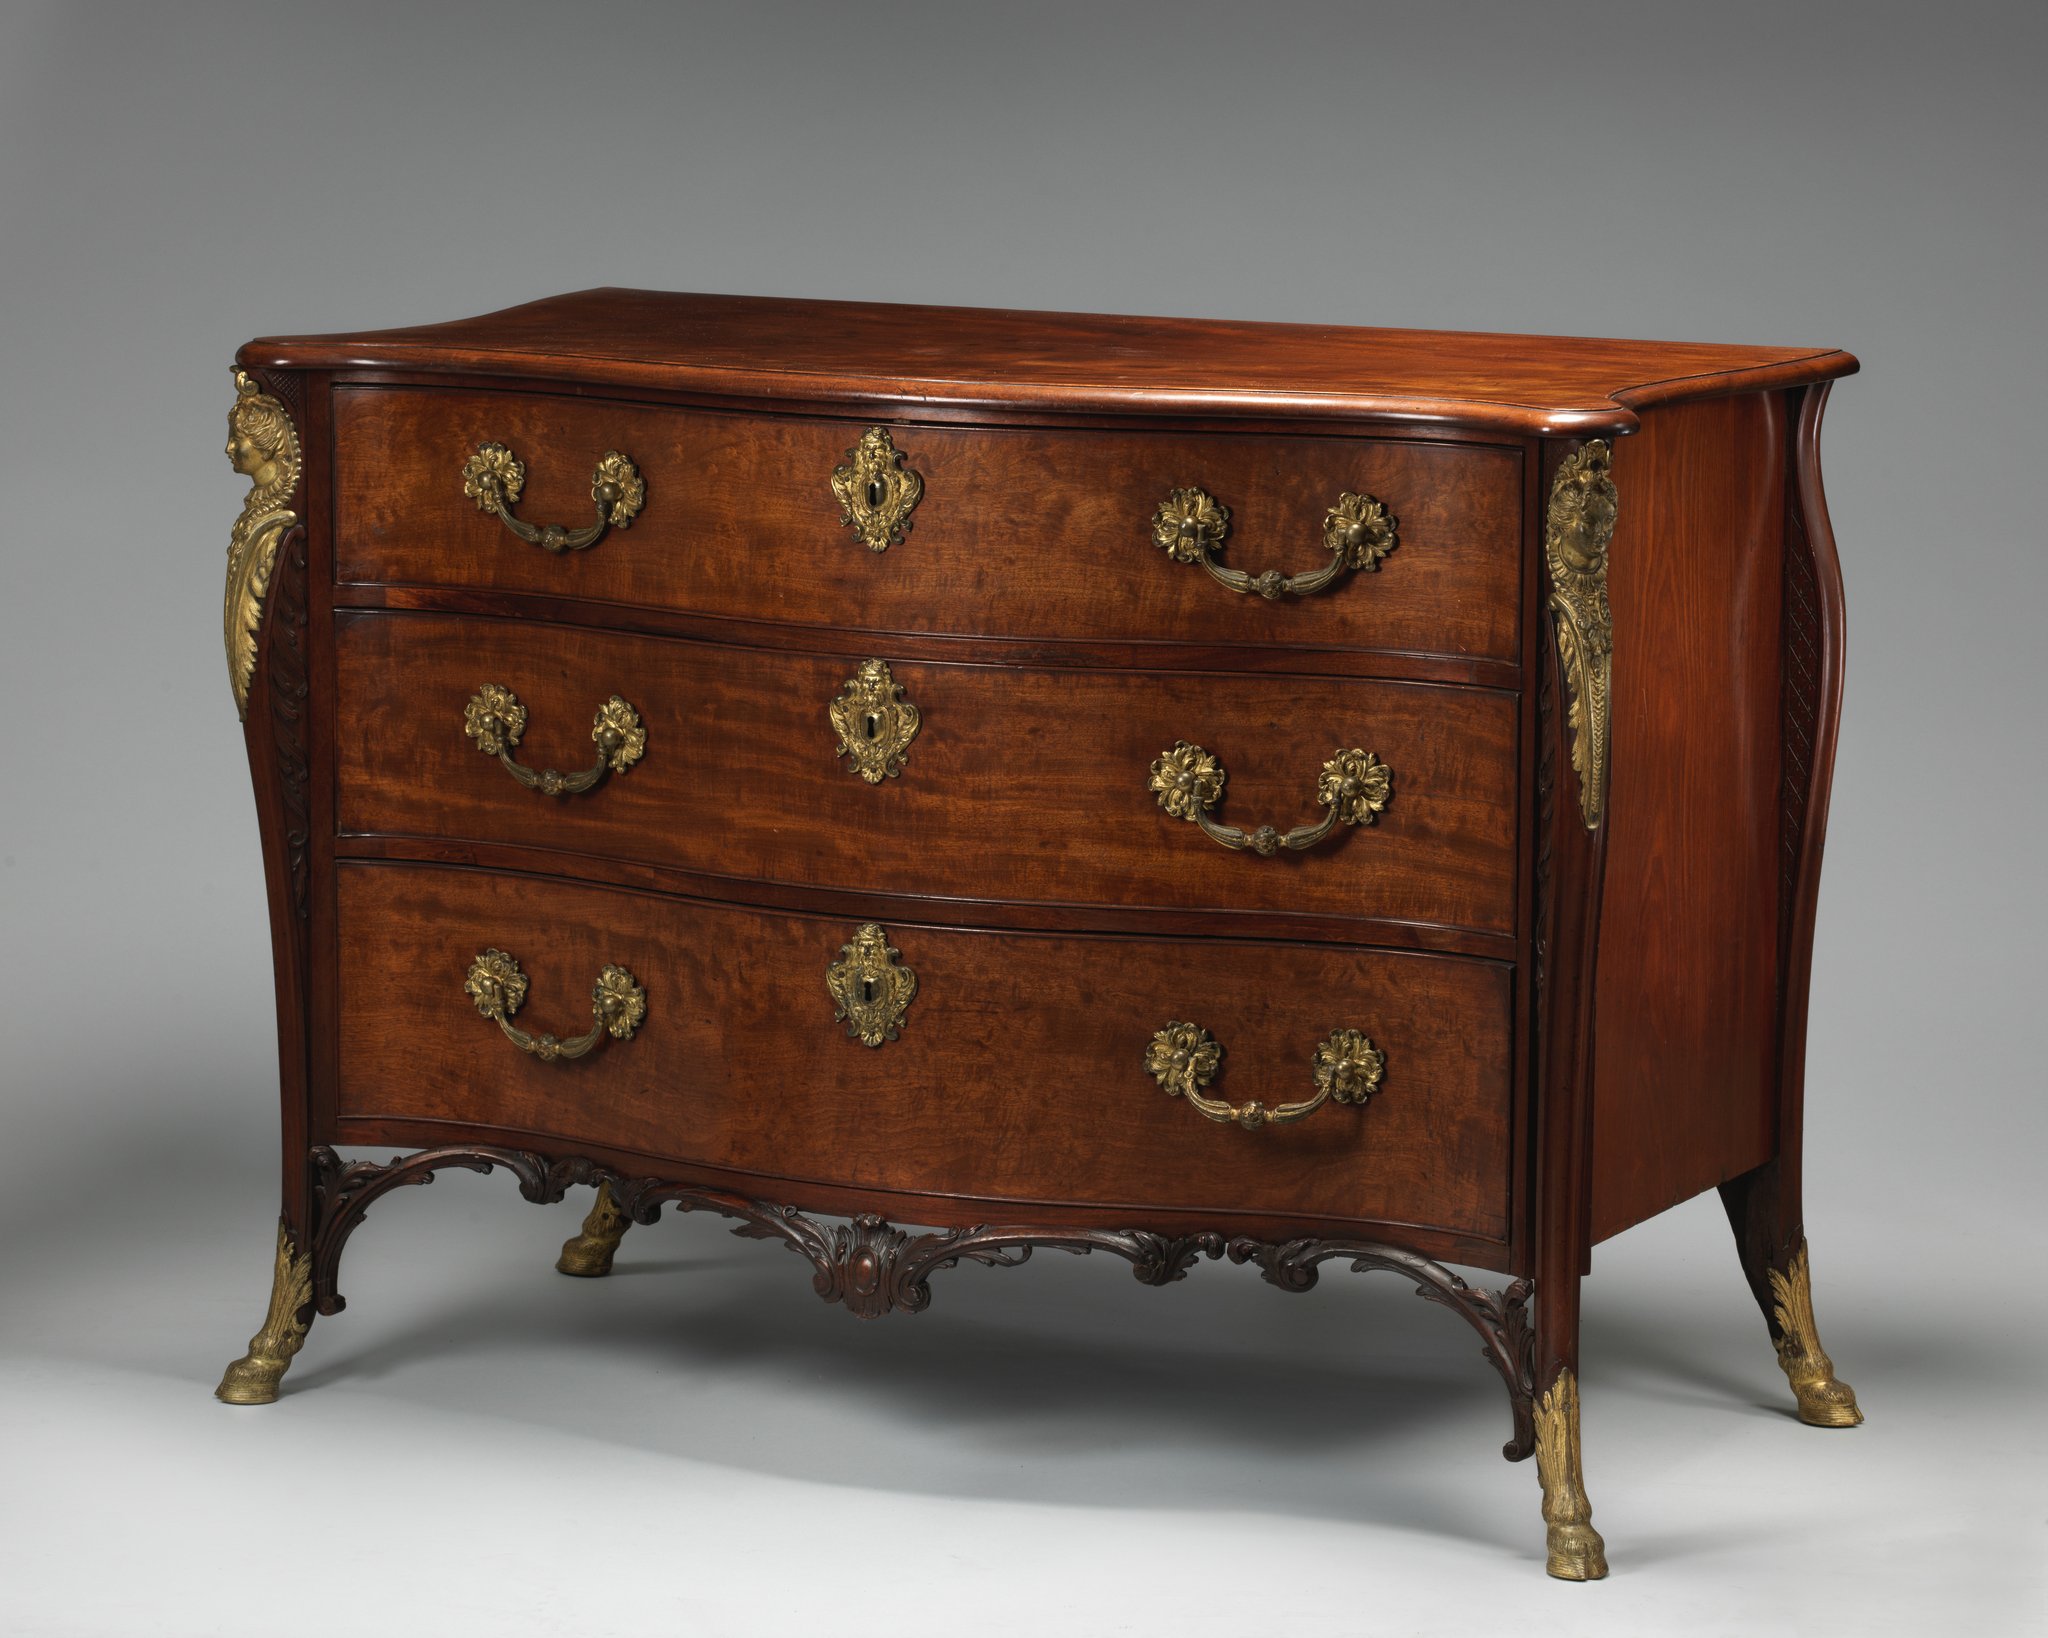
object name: chest of drawer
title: Chest of drawers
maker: william vile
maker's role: maker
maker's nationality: british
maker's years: 1715-1767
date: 1750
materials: gilt bronze, wood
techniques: veneering